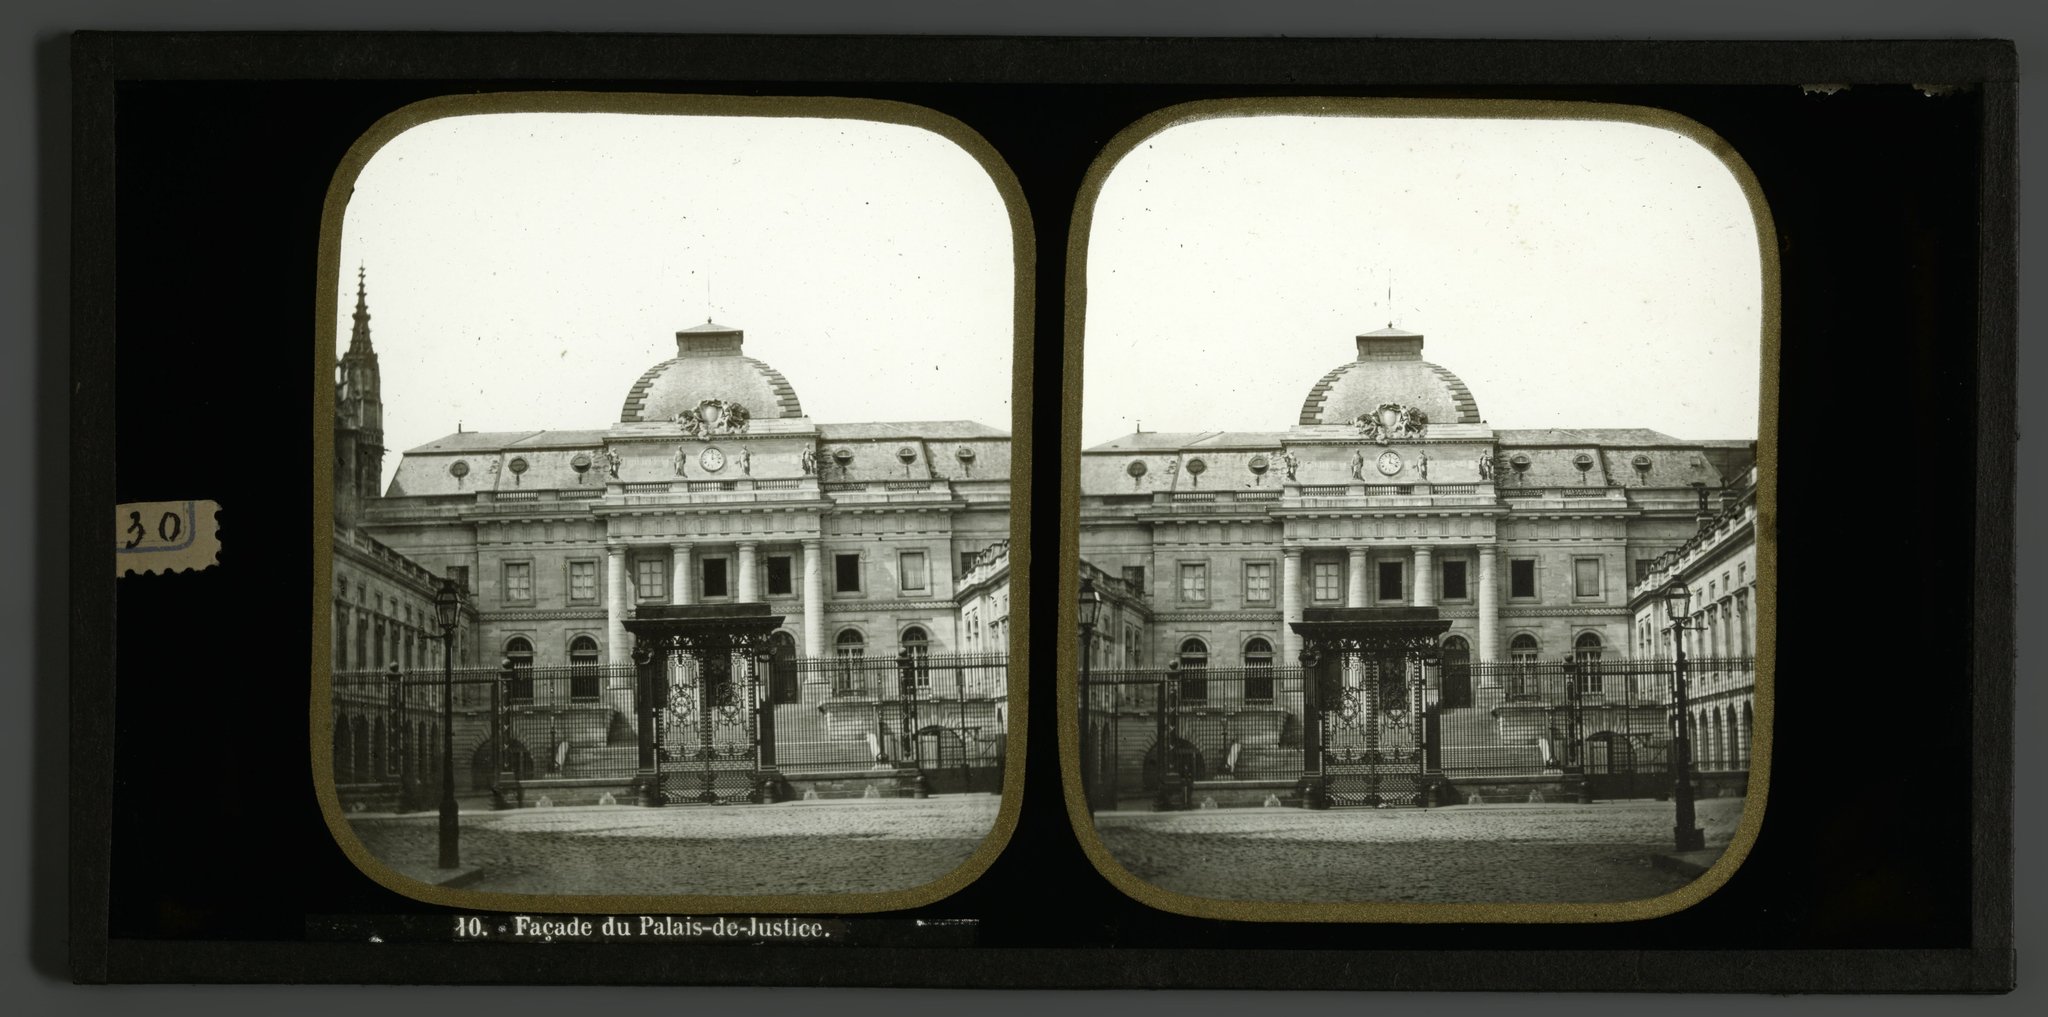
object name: stereoscopic photograph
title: Façade du Palais-de-Justice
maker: Anonymous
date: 1856-1890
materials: glass, paper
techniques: slide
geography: paris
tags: court building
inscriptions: number: ‘30’, number: ‘10’